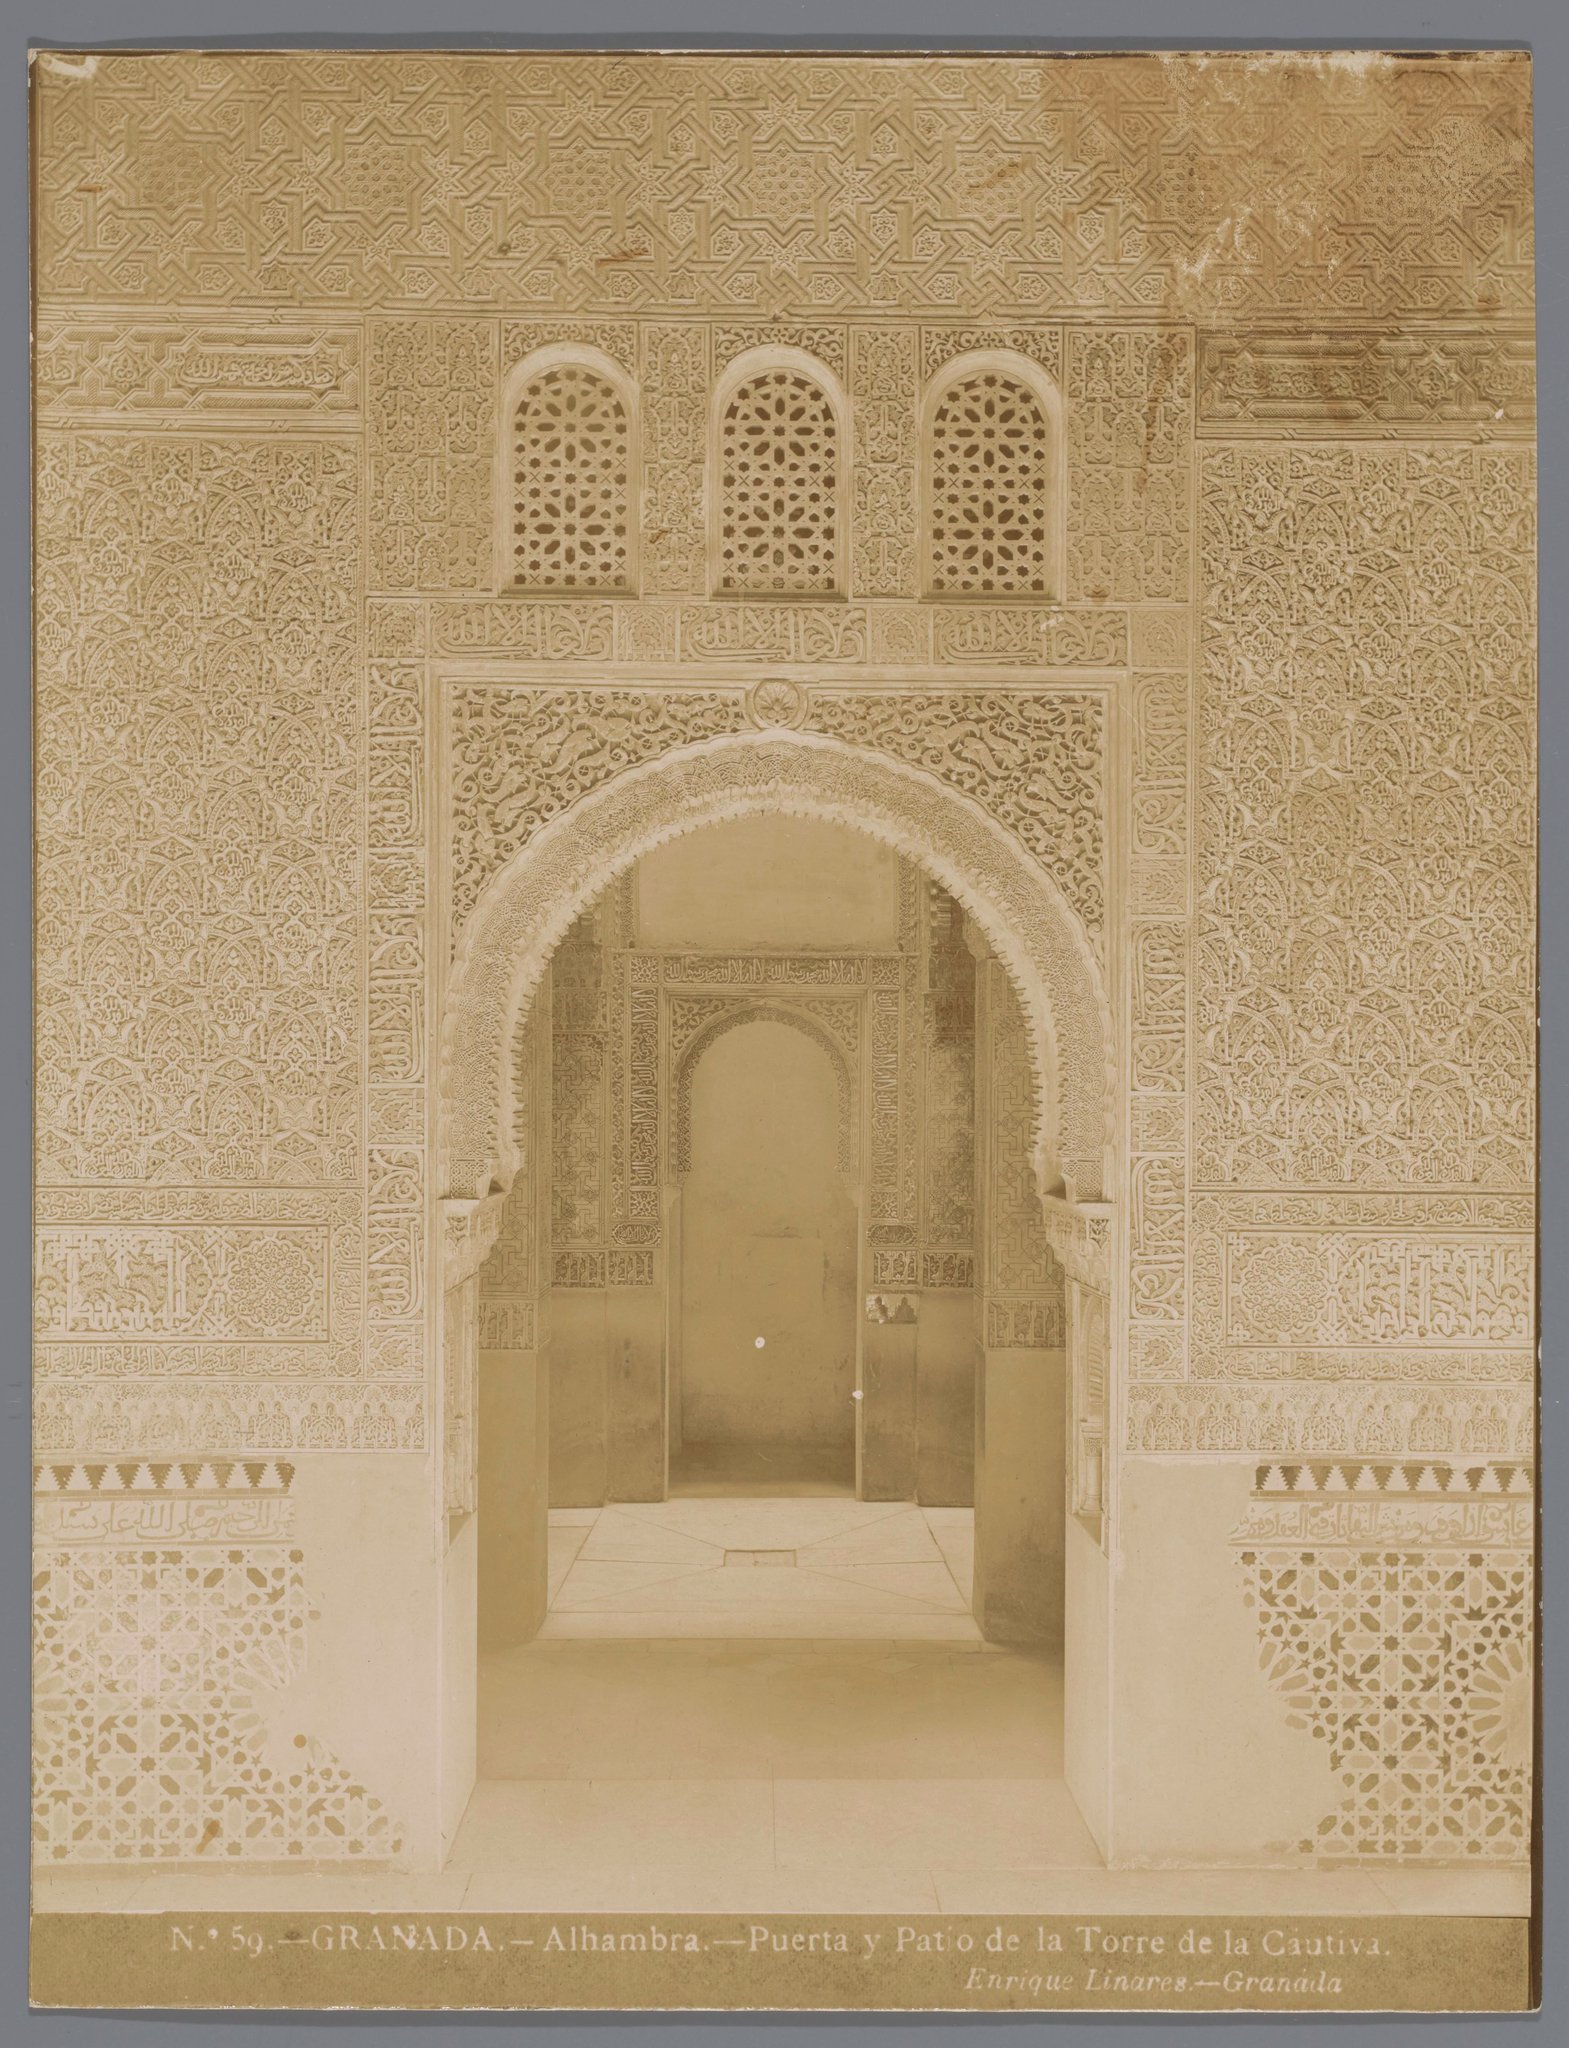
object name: photograph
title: Granada, Alhambra, puerta y Patio de la Torre de la Cautiva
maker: enrique linares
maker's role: fotograaf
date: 1900-1930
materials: paper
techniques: gelatin silver print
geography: granada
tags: palace - aa - civic architecture: inside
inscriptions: number: ‘No 59.’